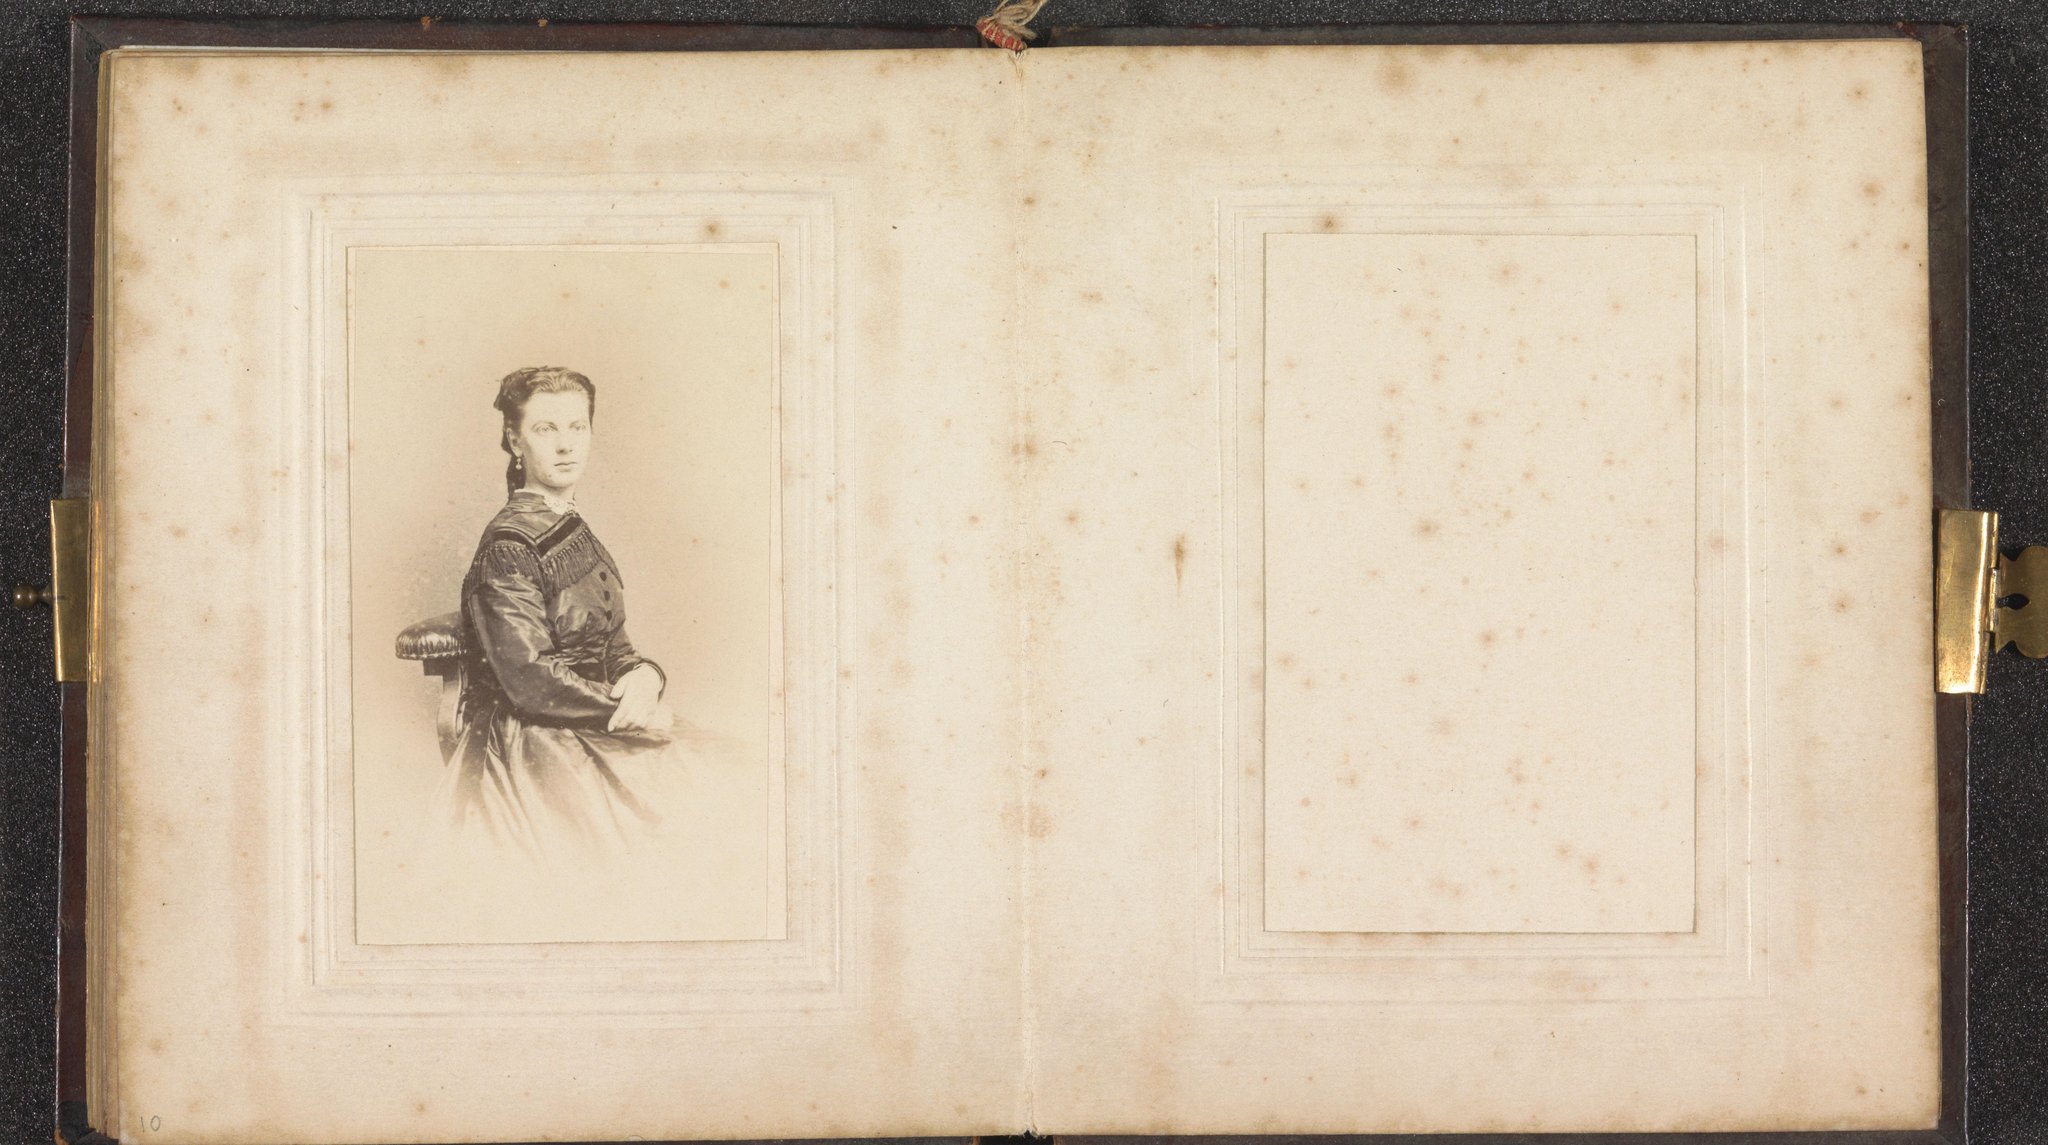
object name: photograph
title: Portret van een vrouw, zittend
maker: c. j. korsten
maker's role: painter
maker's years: 1829-1914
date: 1860-1875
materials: cardboard, paper, photographic support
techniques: albumen print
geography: zierikzee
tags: adult woman, studio requisites ~ photographer, historical persons, family life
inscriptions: address: ‘Zierikzee’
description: Onderdeel van Fotoalbum met cartes-de-visite van een Zeeuwse familie.